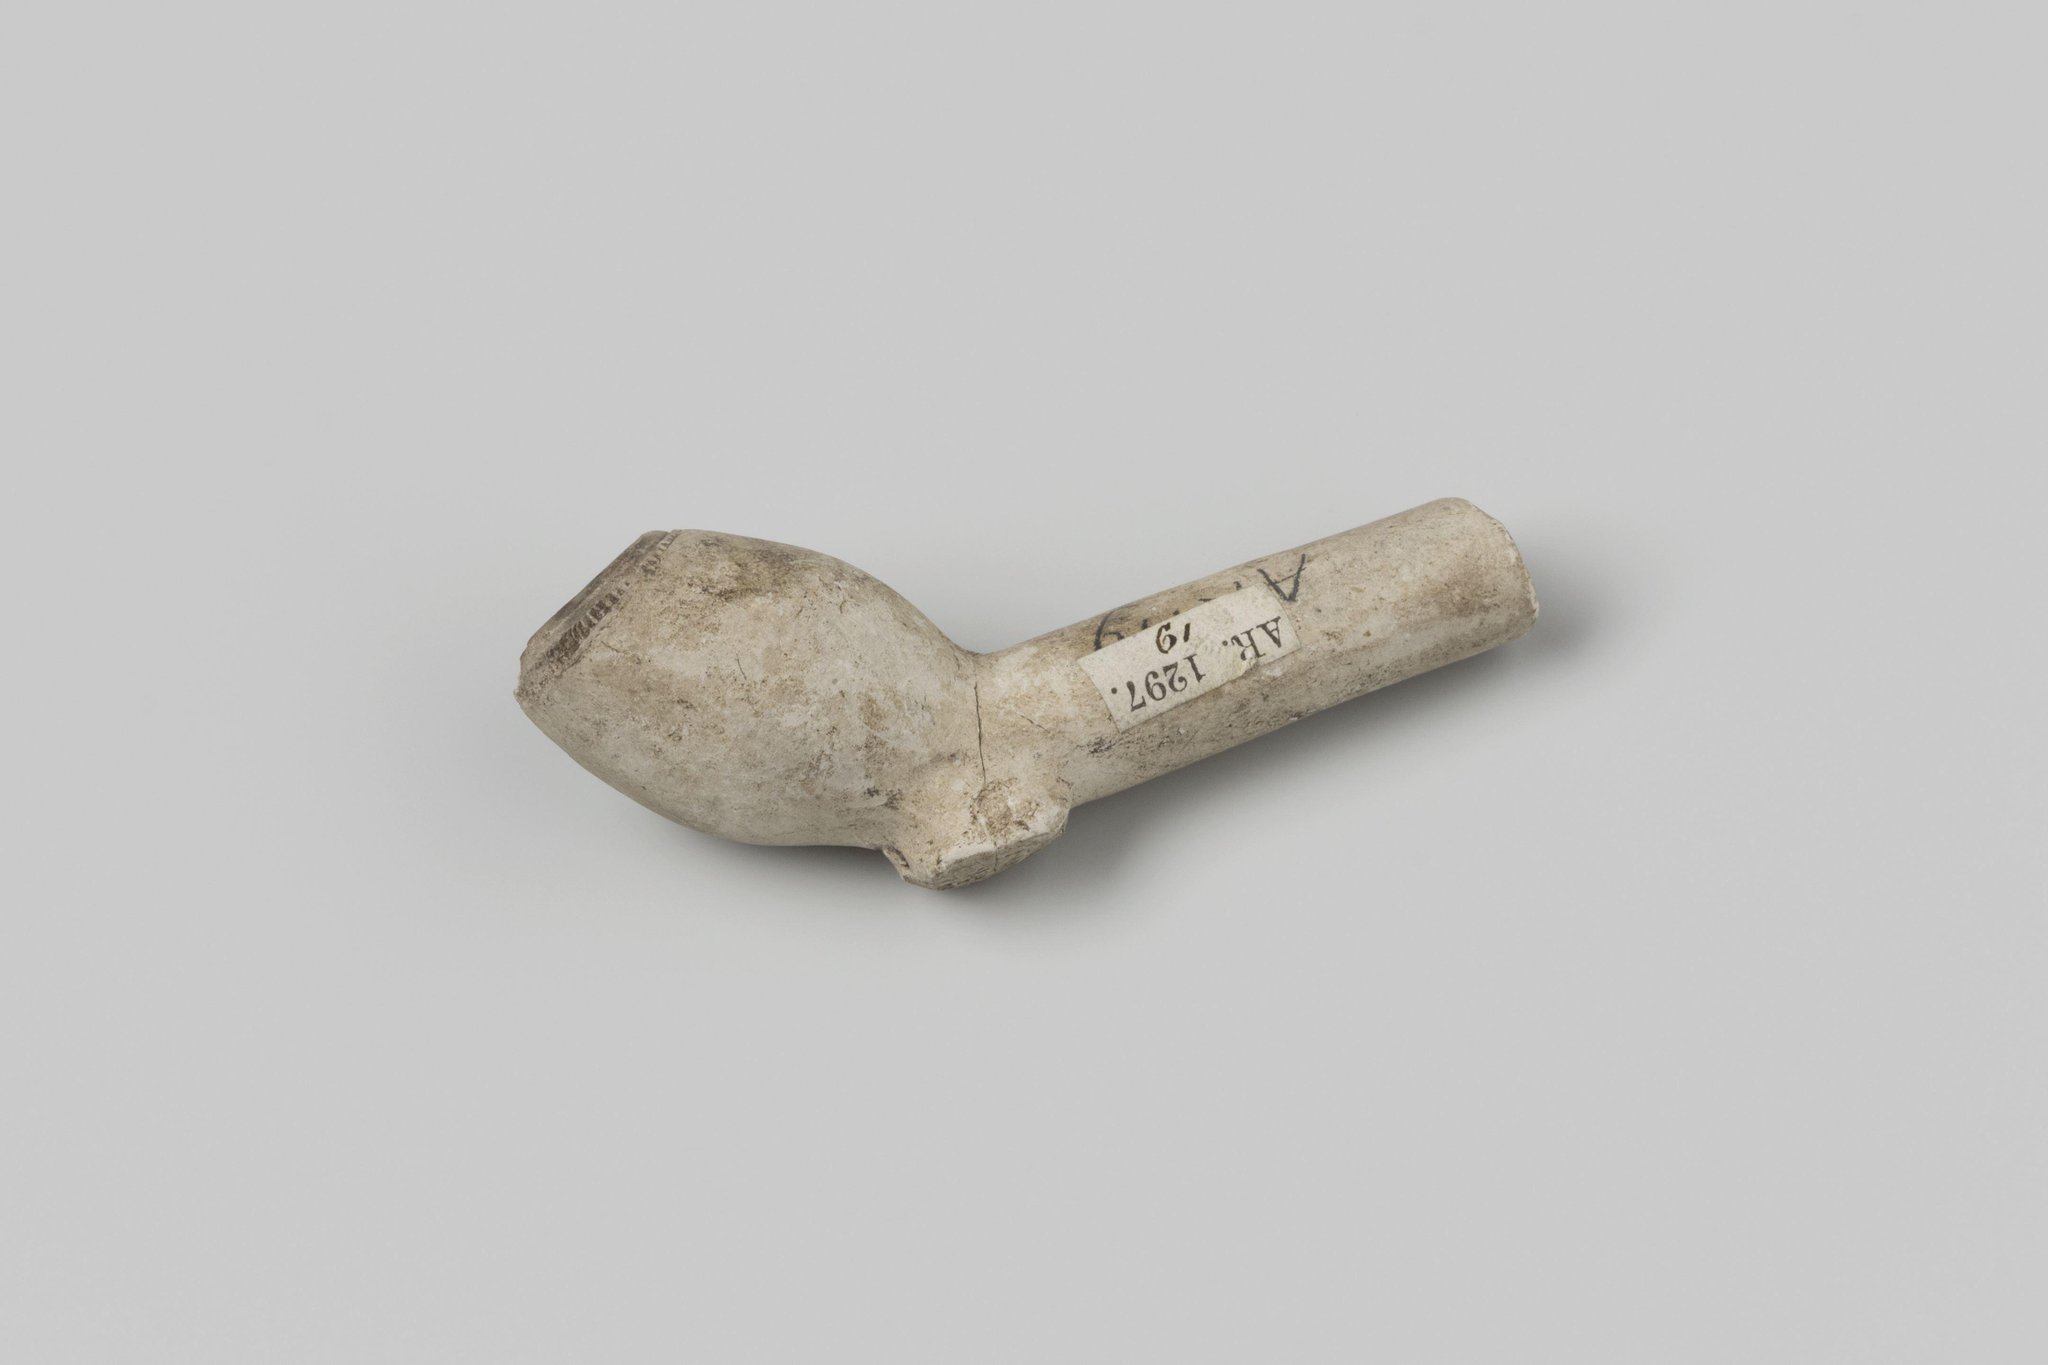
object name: pipe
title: Fragment tabakspijp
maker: Anonymous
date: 1635-1650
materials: clay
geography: gouda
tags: the hague, rotterdam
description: Fragment tabakspijp. Van de opgravingen op de Hofstede Arentsburg 1827-1831 onder toezicht van Professor Reuvens.